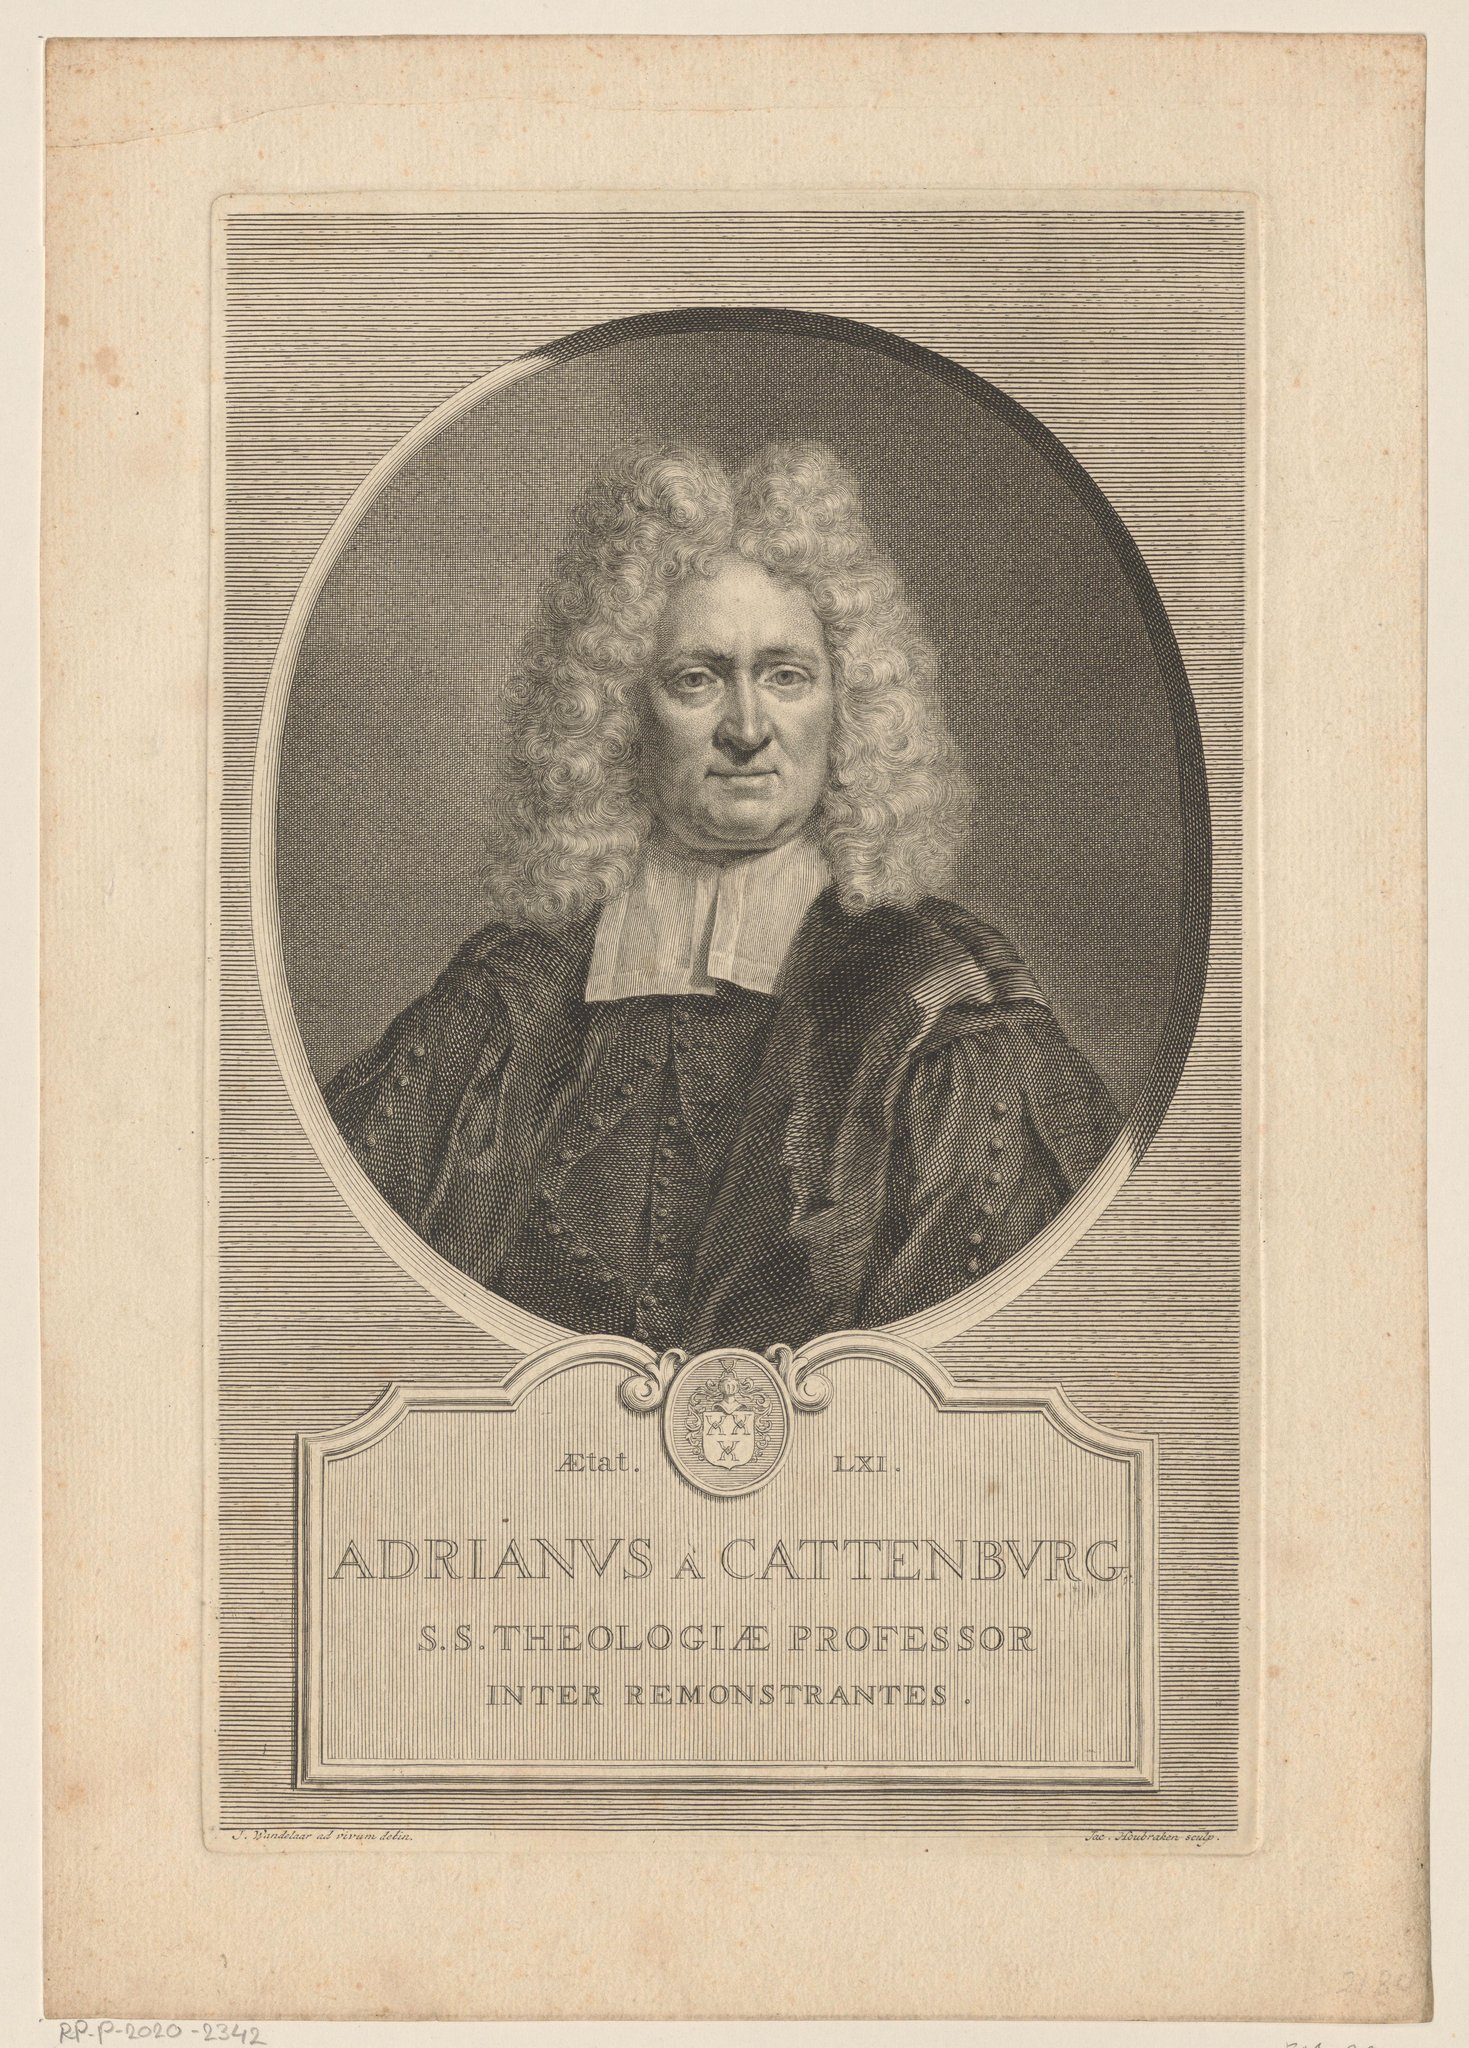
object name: print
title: Portret van Adriaan van Cattenburgh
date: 1725-1780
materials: paper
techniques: engraving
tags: rotterdam, utrecht, adriaan van cattenburgh, historical persons